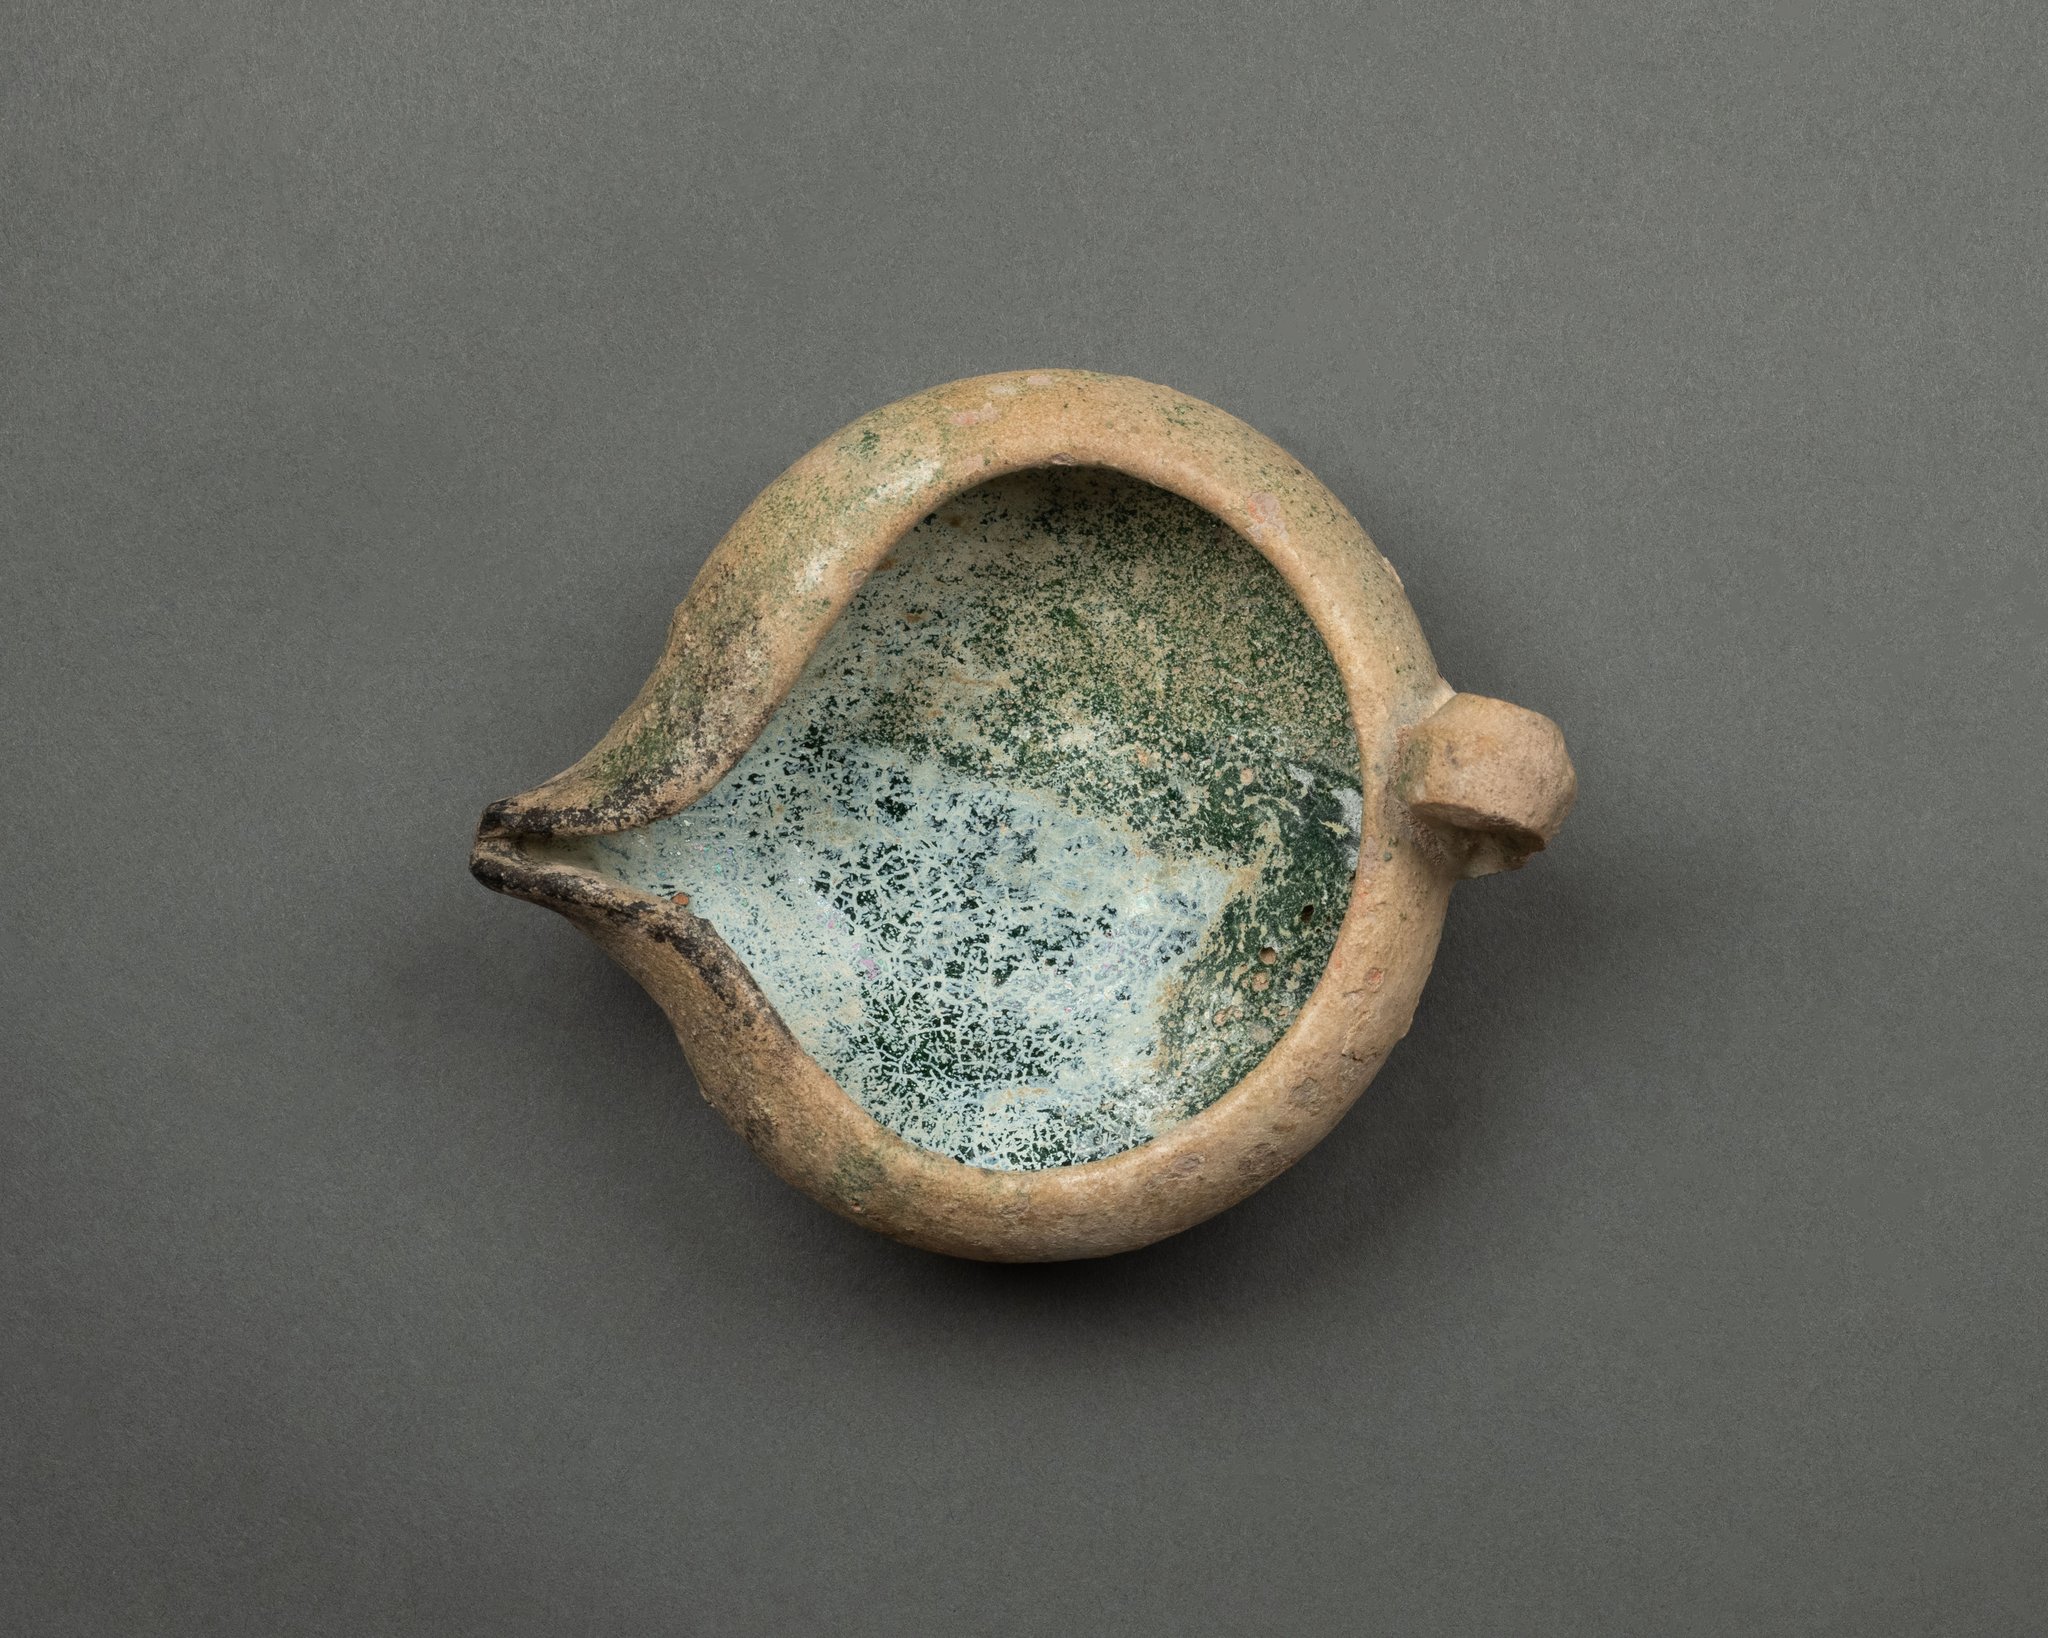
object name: lamp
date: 801-1000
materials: earthenware, glaze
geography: iran